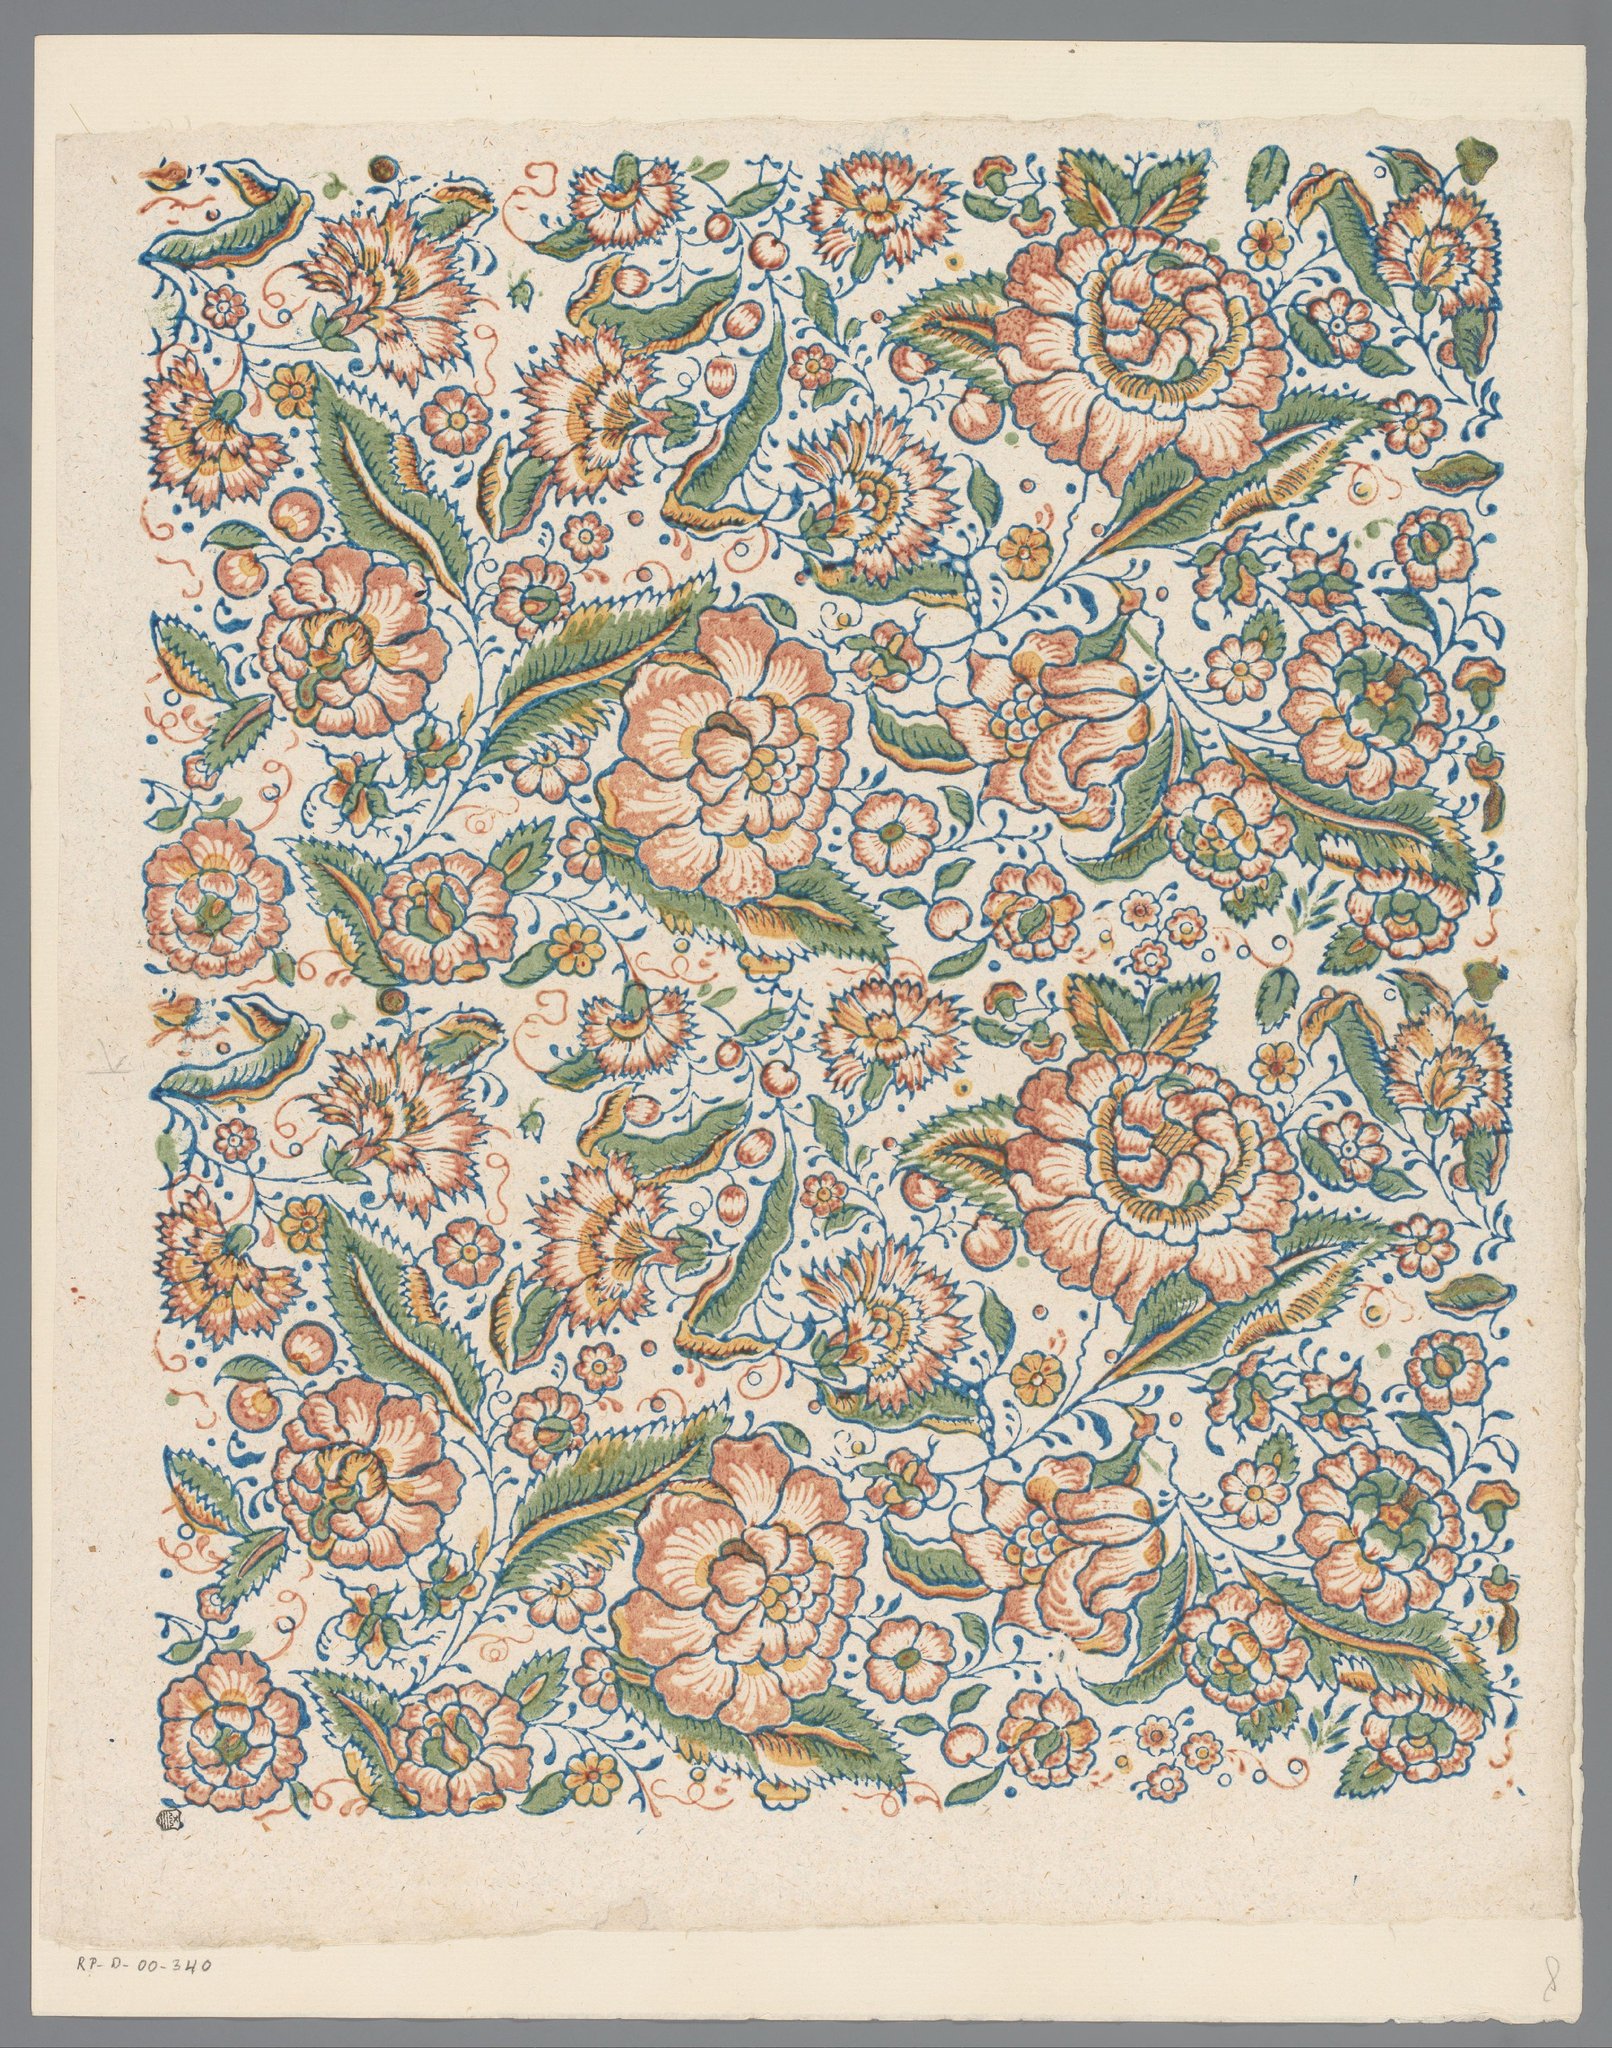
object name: printed paper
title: Blad met regelmatig verdeelde bloemen met vruchten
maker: Anonymous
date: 1700-1850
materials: paper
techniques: printing block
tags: ornament derived from plant forms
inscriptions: collector's mark: Lugt 2760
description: Blad met regelmatig over het blad verdeelde bloemen met vruchten. Links en rechts identieke helften.